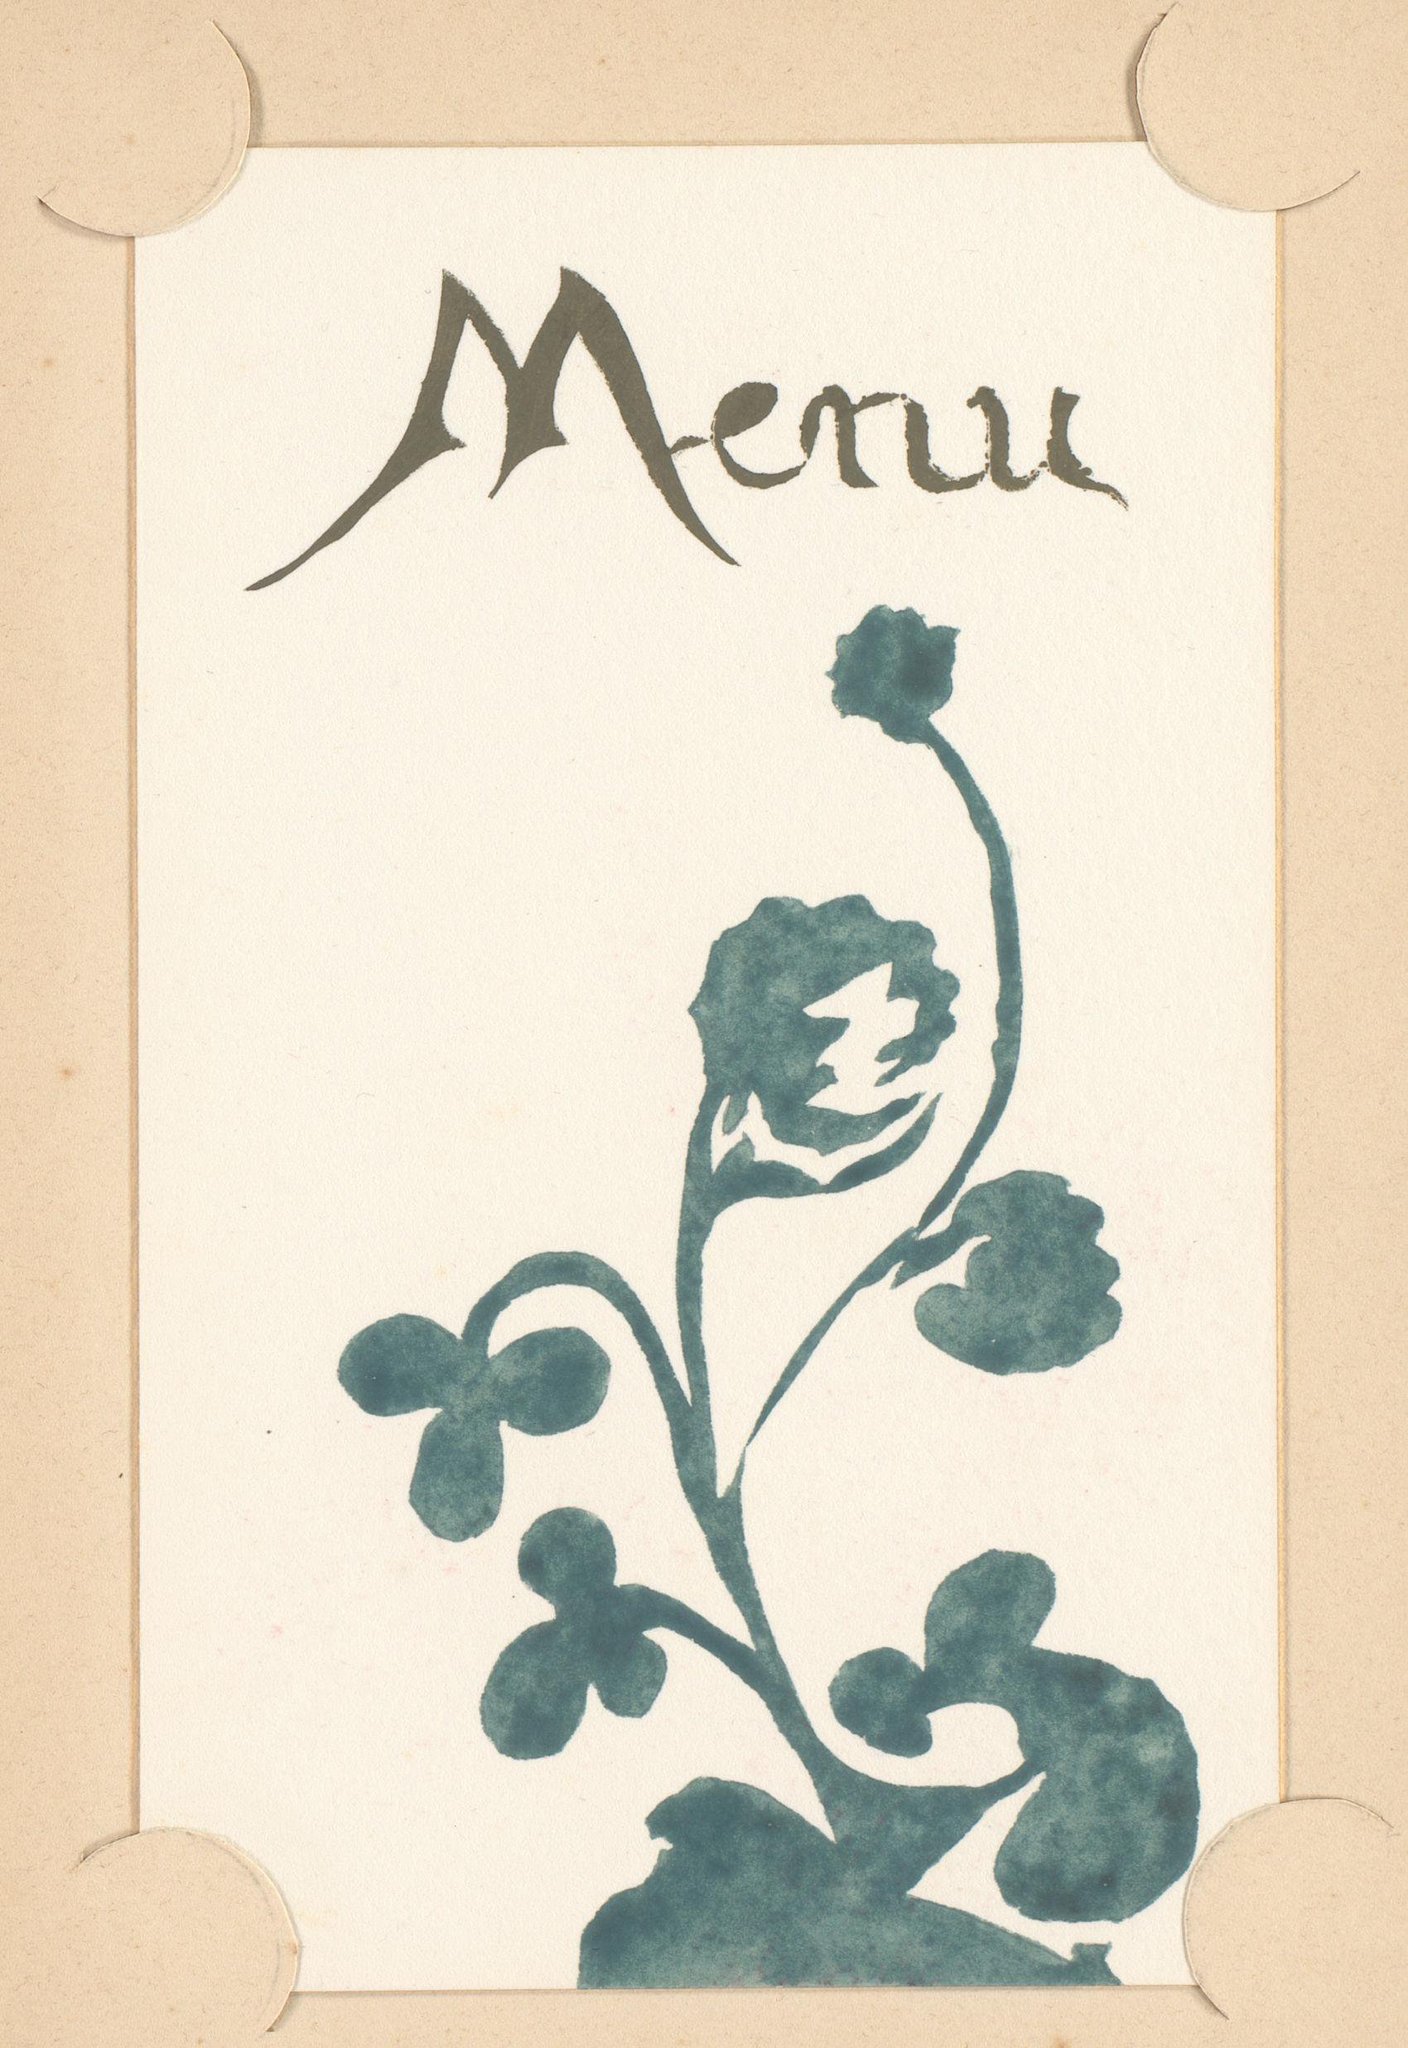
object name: menu, menukaart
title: Menukaart met botanische decoratie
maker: theo colenbrander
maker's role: draughtsman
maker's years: 1841-1930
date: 1851-1930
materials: paper, pencil, paint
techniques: brush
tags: plants (in general)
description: Groot het woord 'Menu' met daaronder het silhouet van een plant. Deze tekening maakt deel uit van een album.